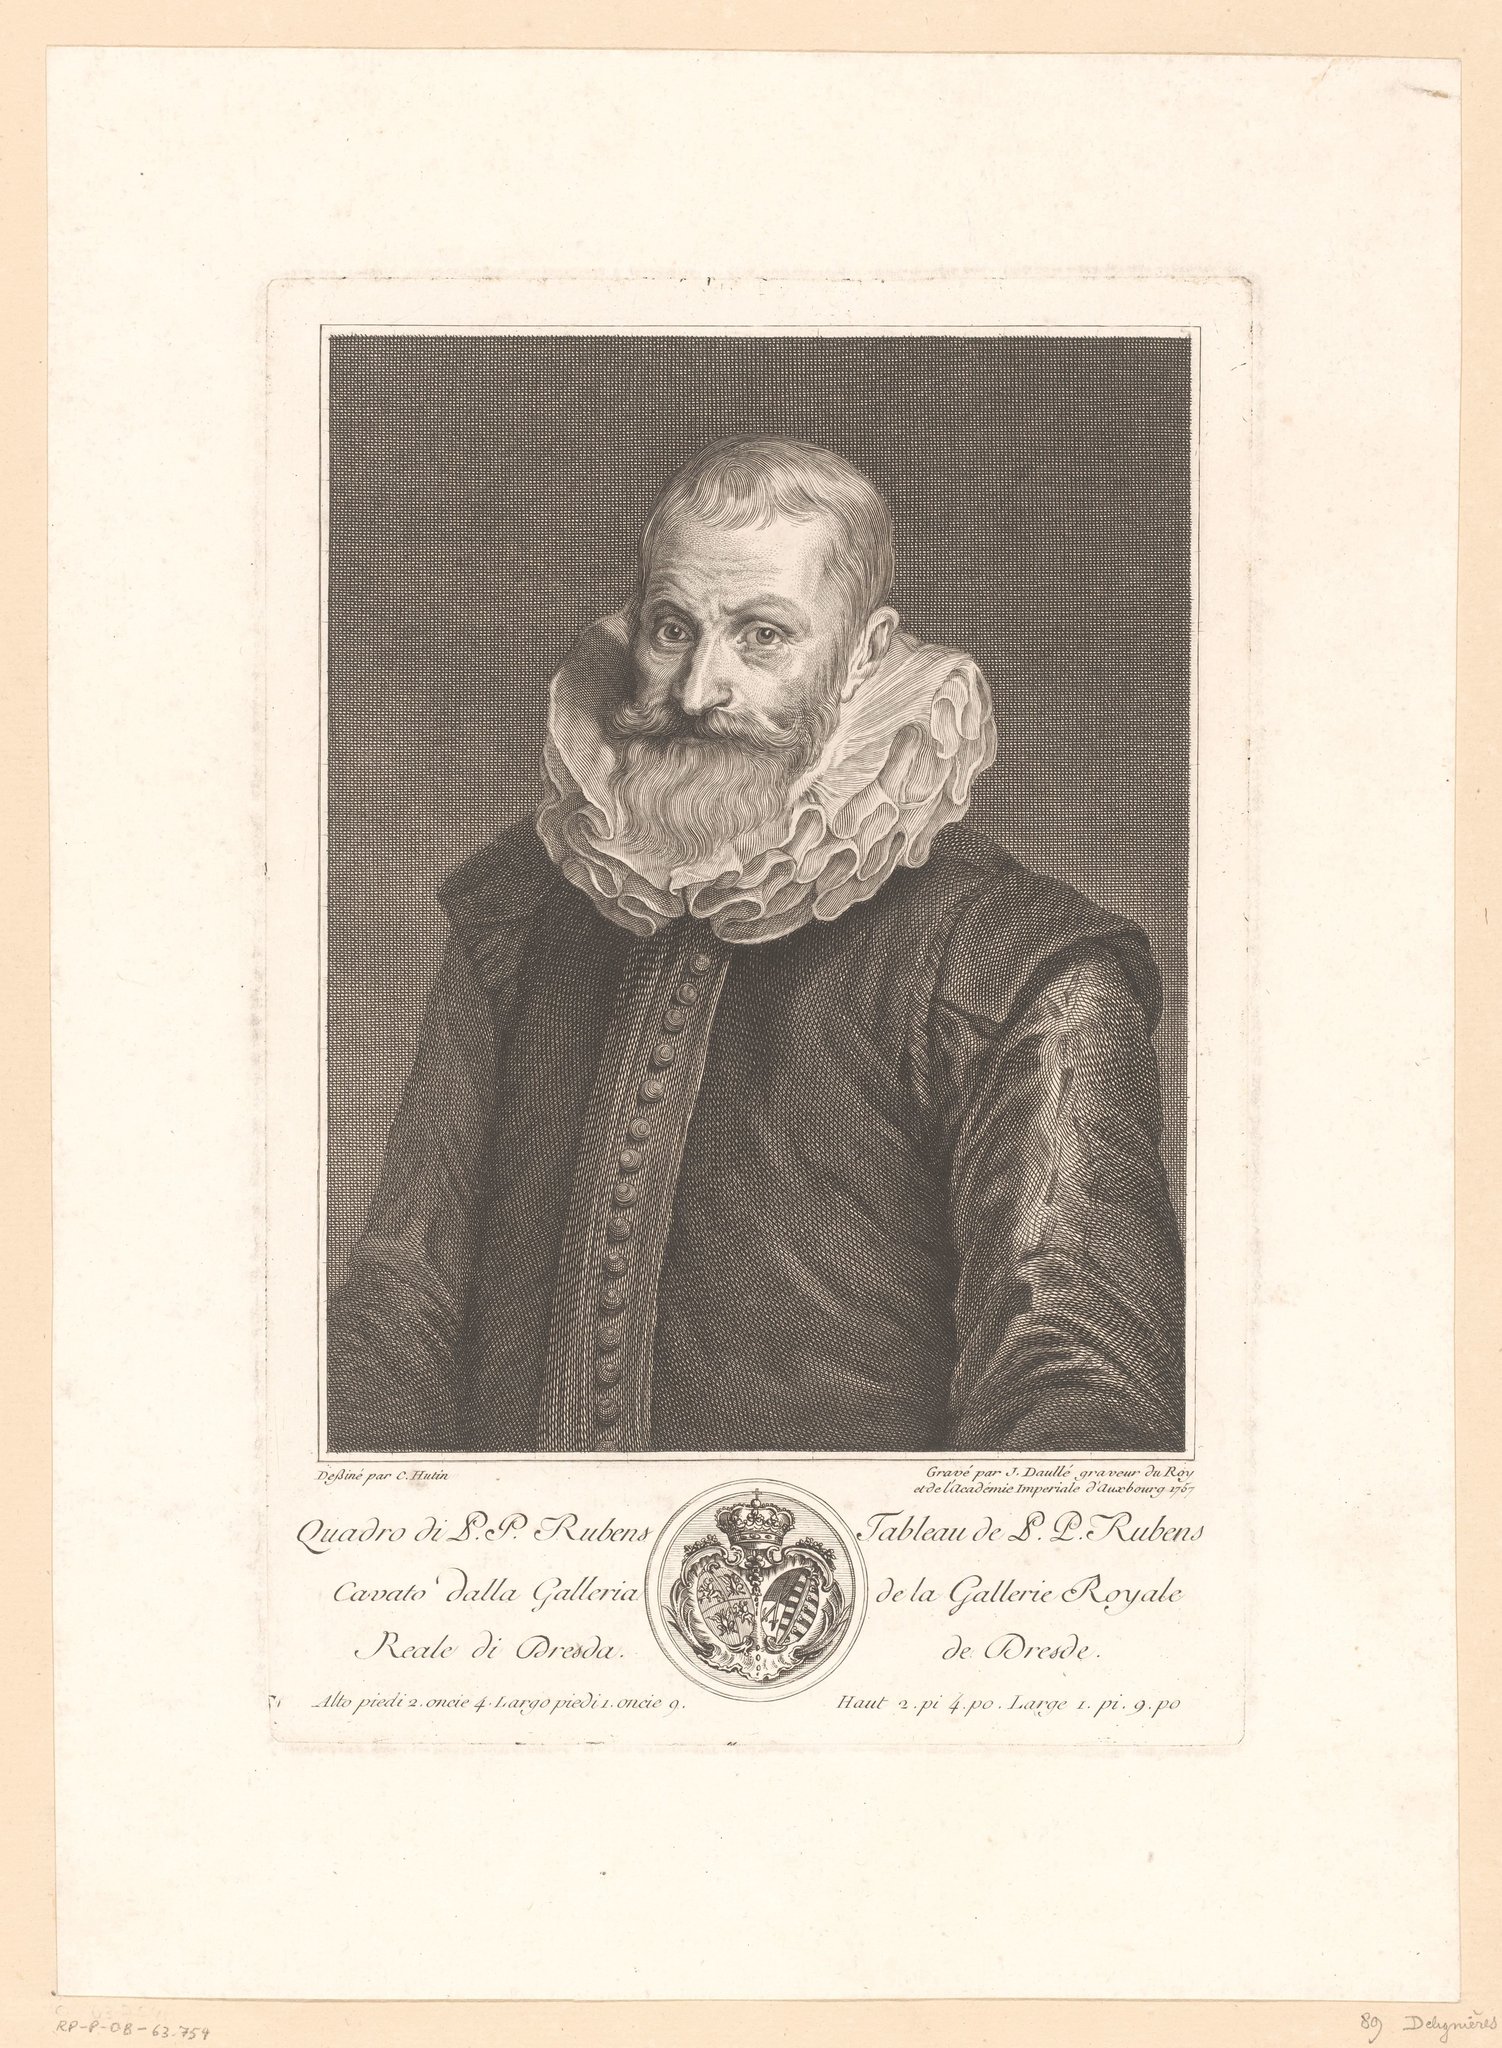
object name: print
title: Portret van een oude man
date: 1757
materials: paper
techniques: engraving, etching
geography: france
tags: historical persons, old man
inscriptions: collector's mark: Lugt 240